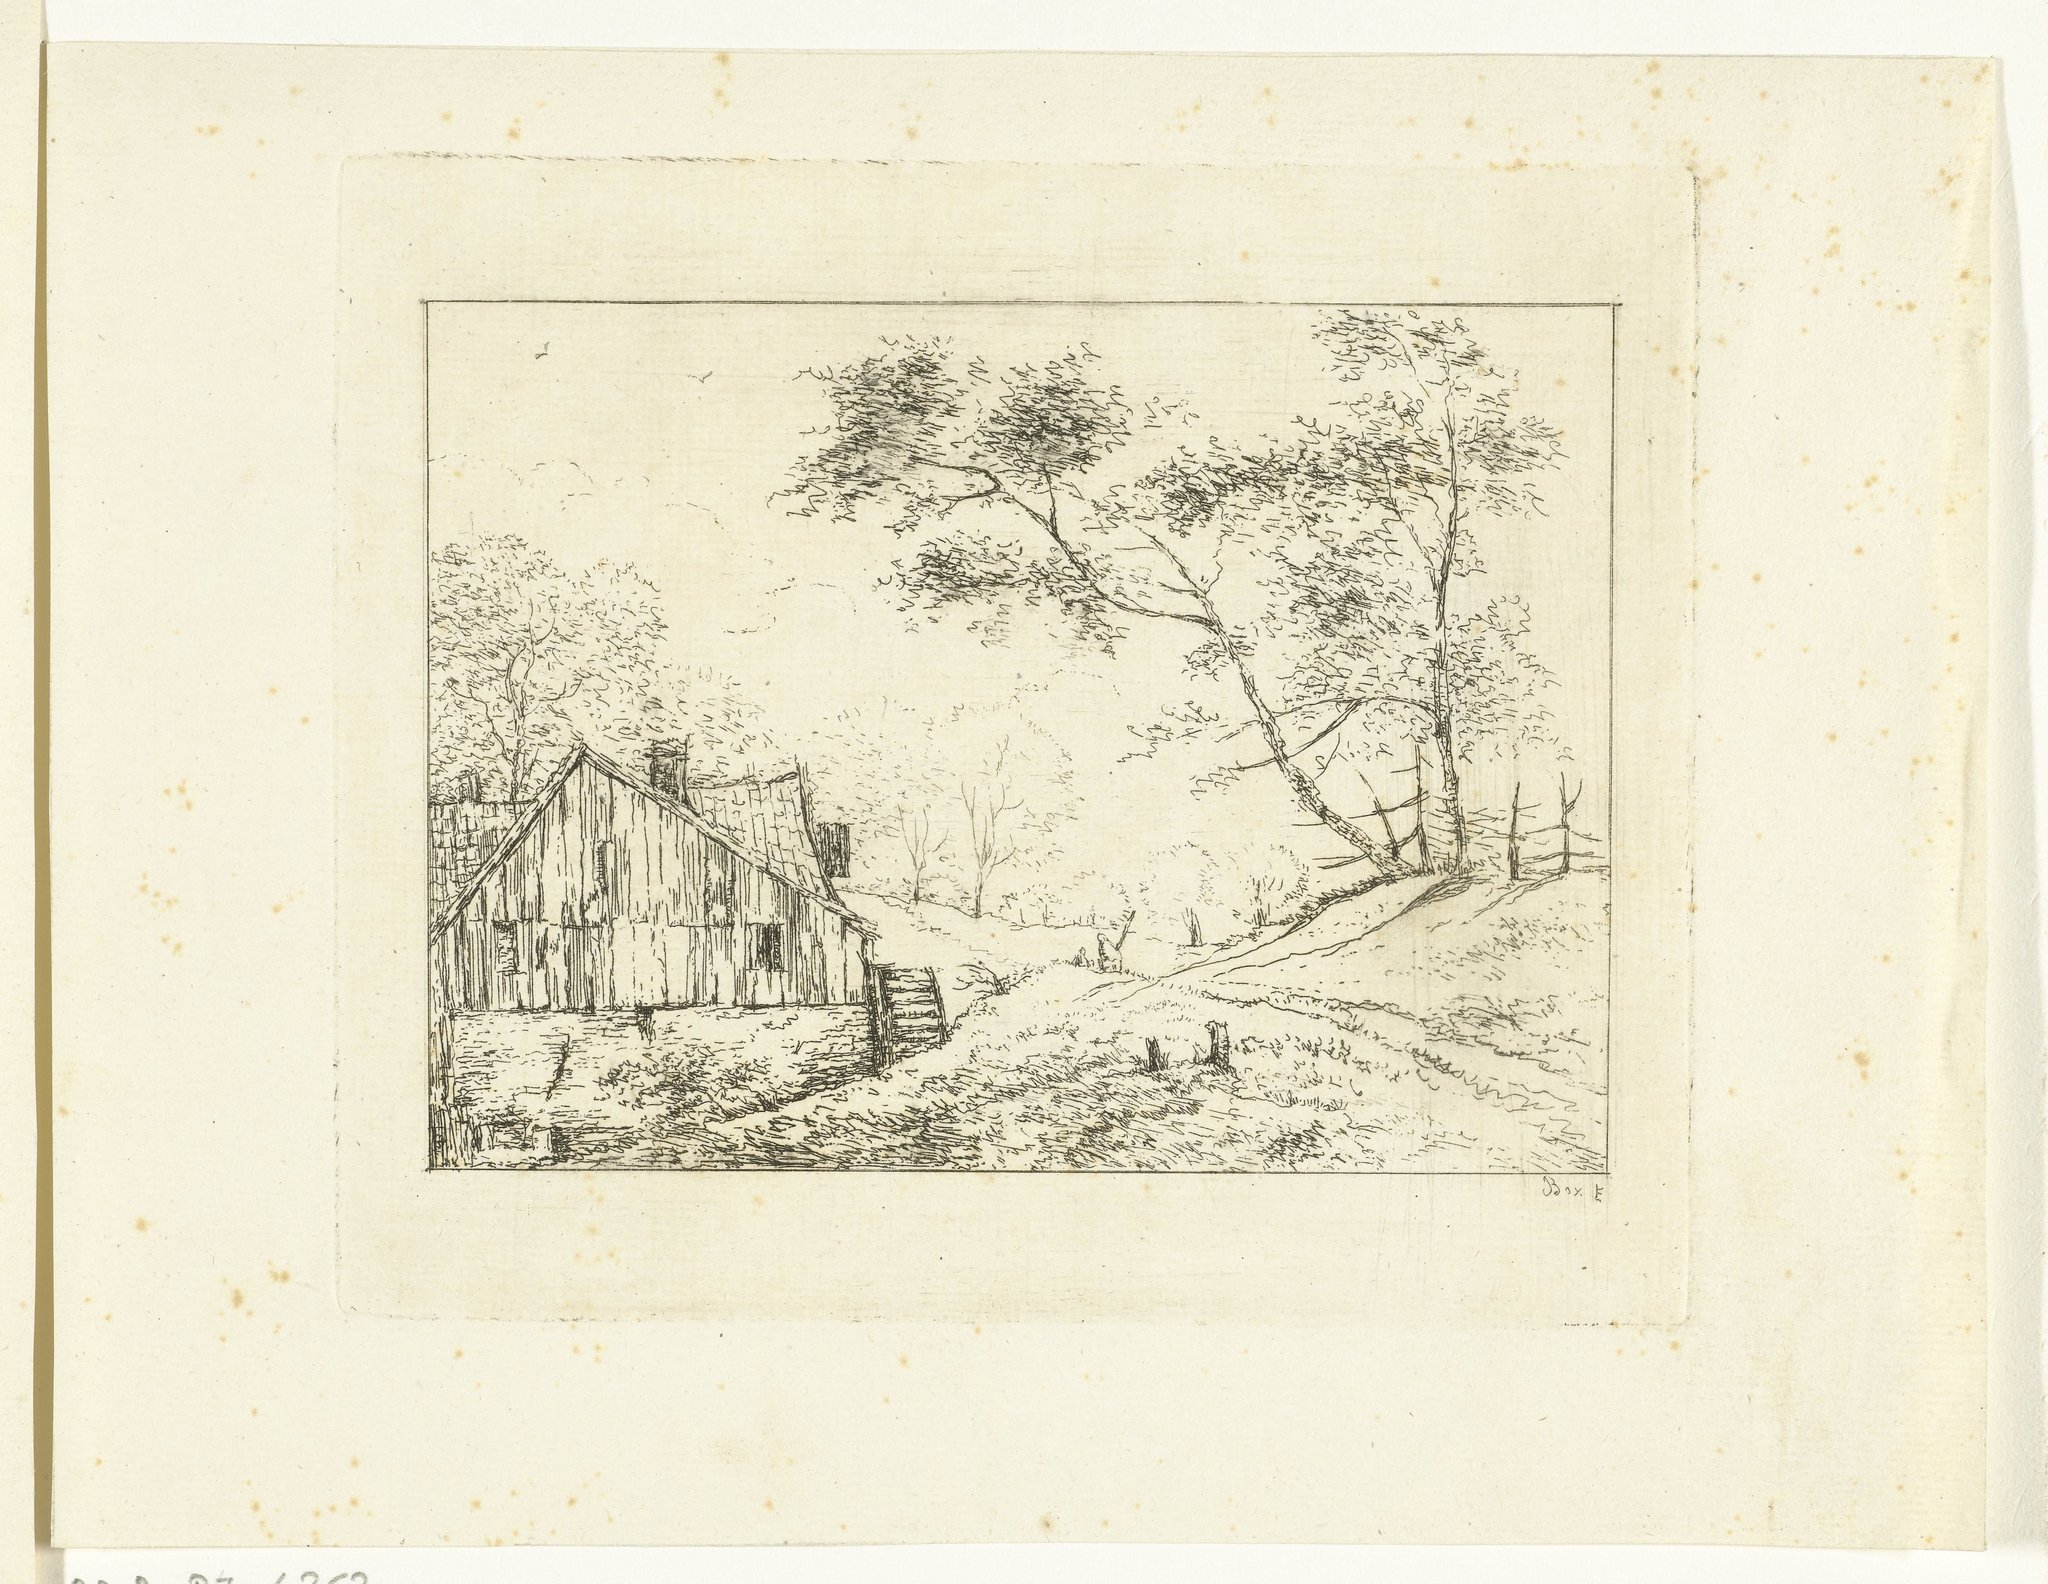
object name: print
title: Watermolen, rechts twee berken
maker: hans willem box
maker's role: print maker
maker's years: 1790-1841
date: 1805-1841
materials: paper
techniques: etching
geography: netherlands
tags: watermill in landscape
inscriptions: collector's mark: Lugt 2228